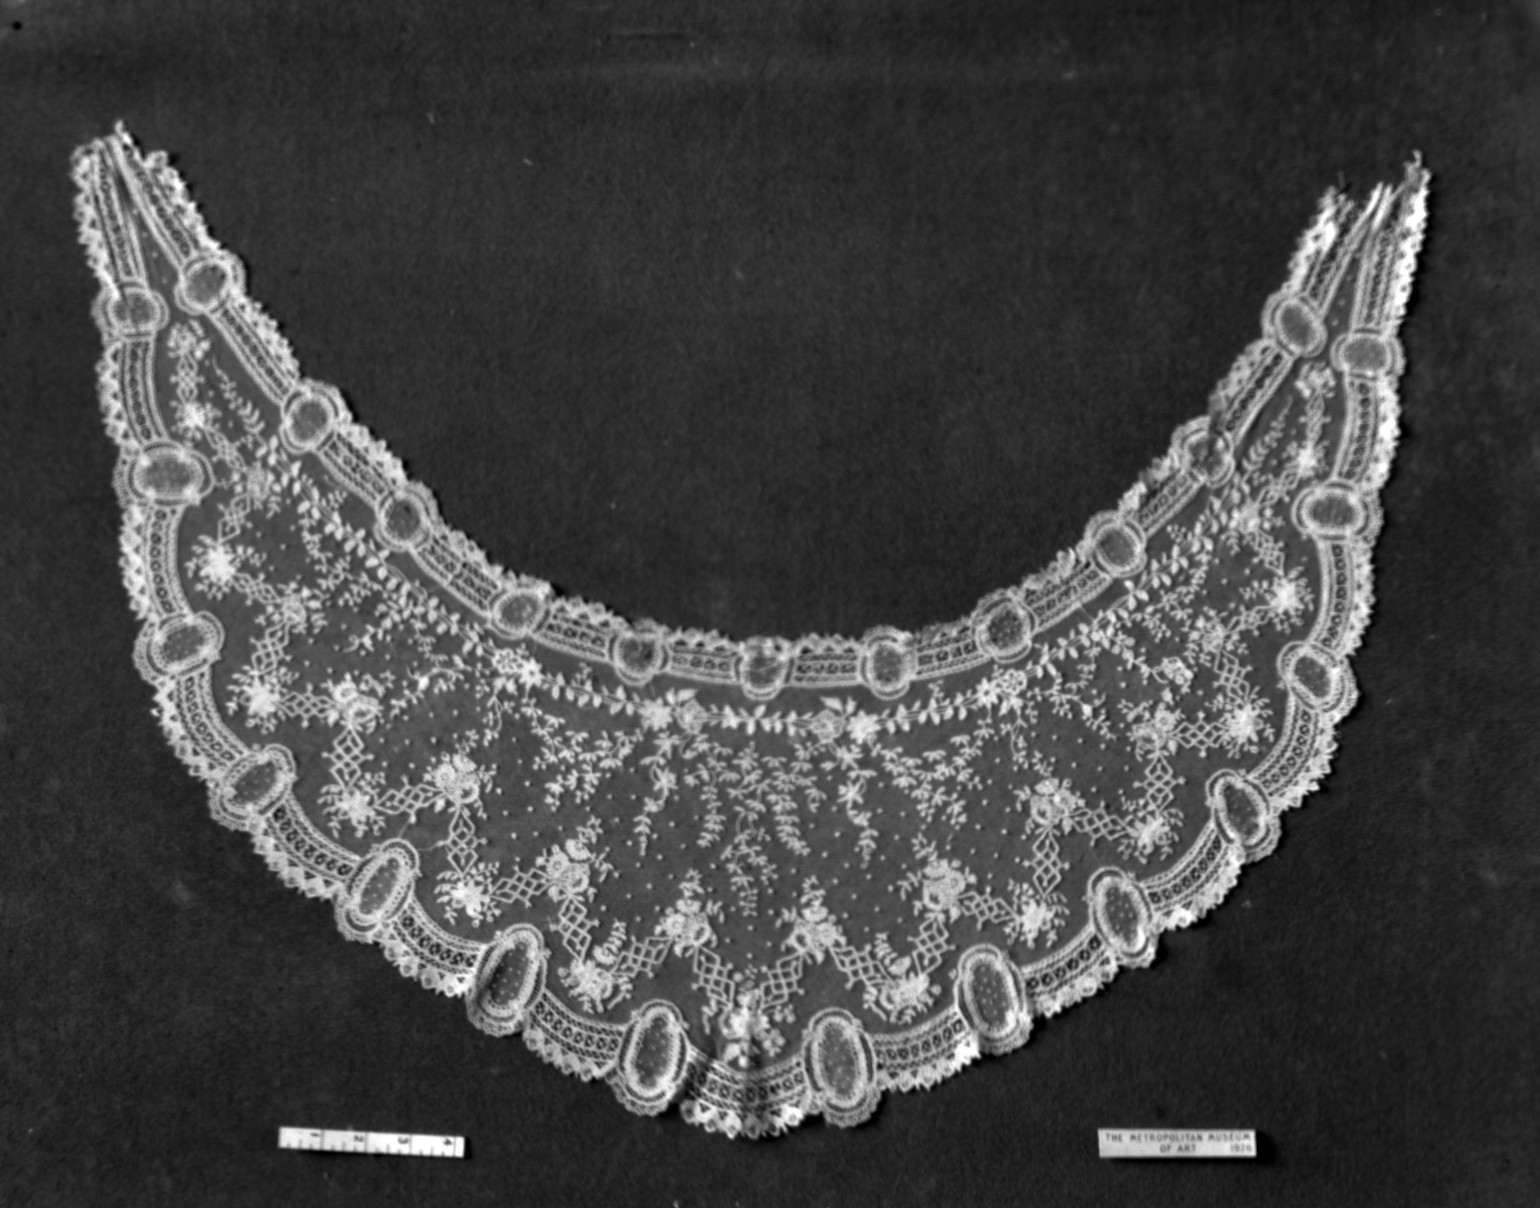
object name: pelerine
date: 1801-1850